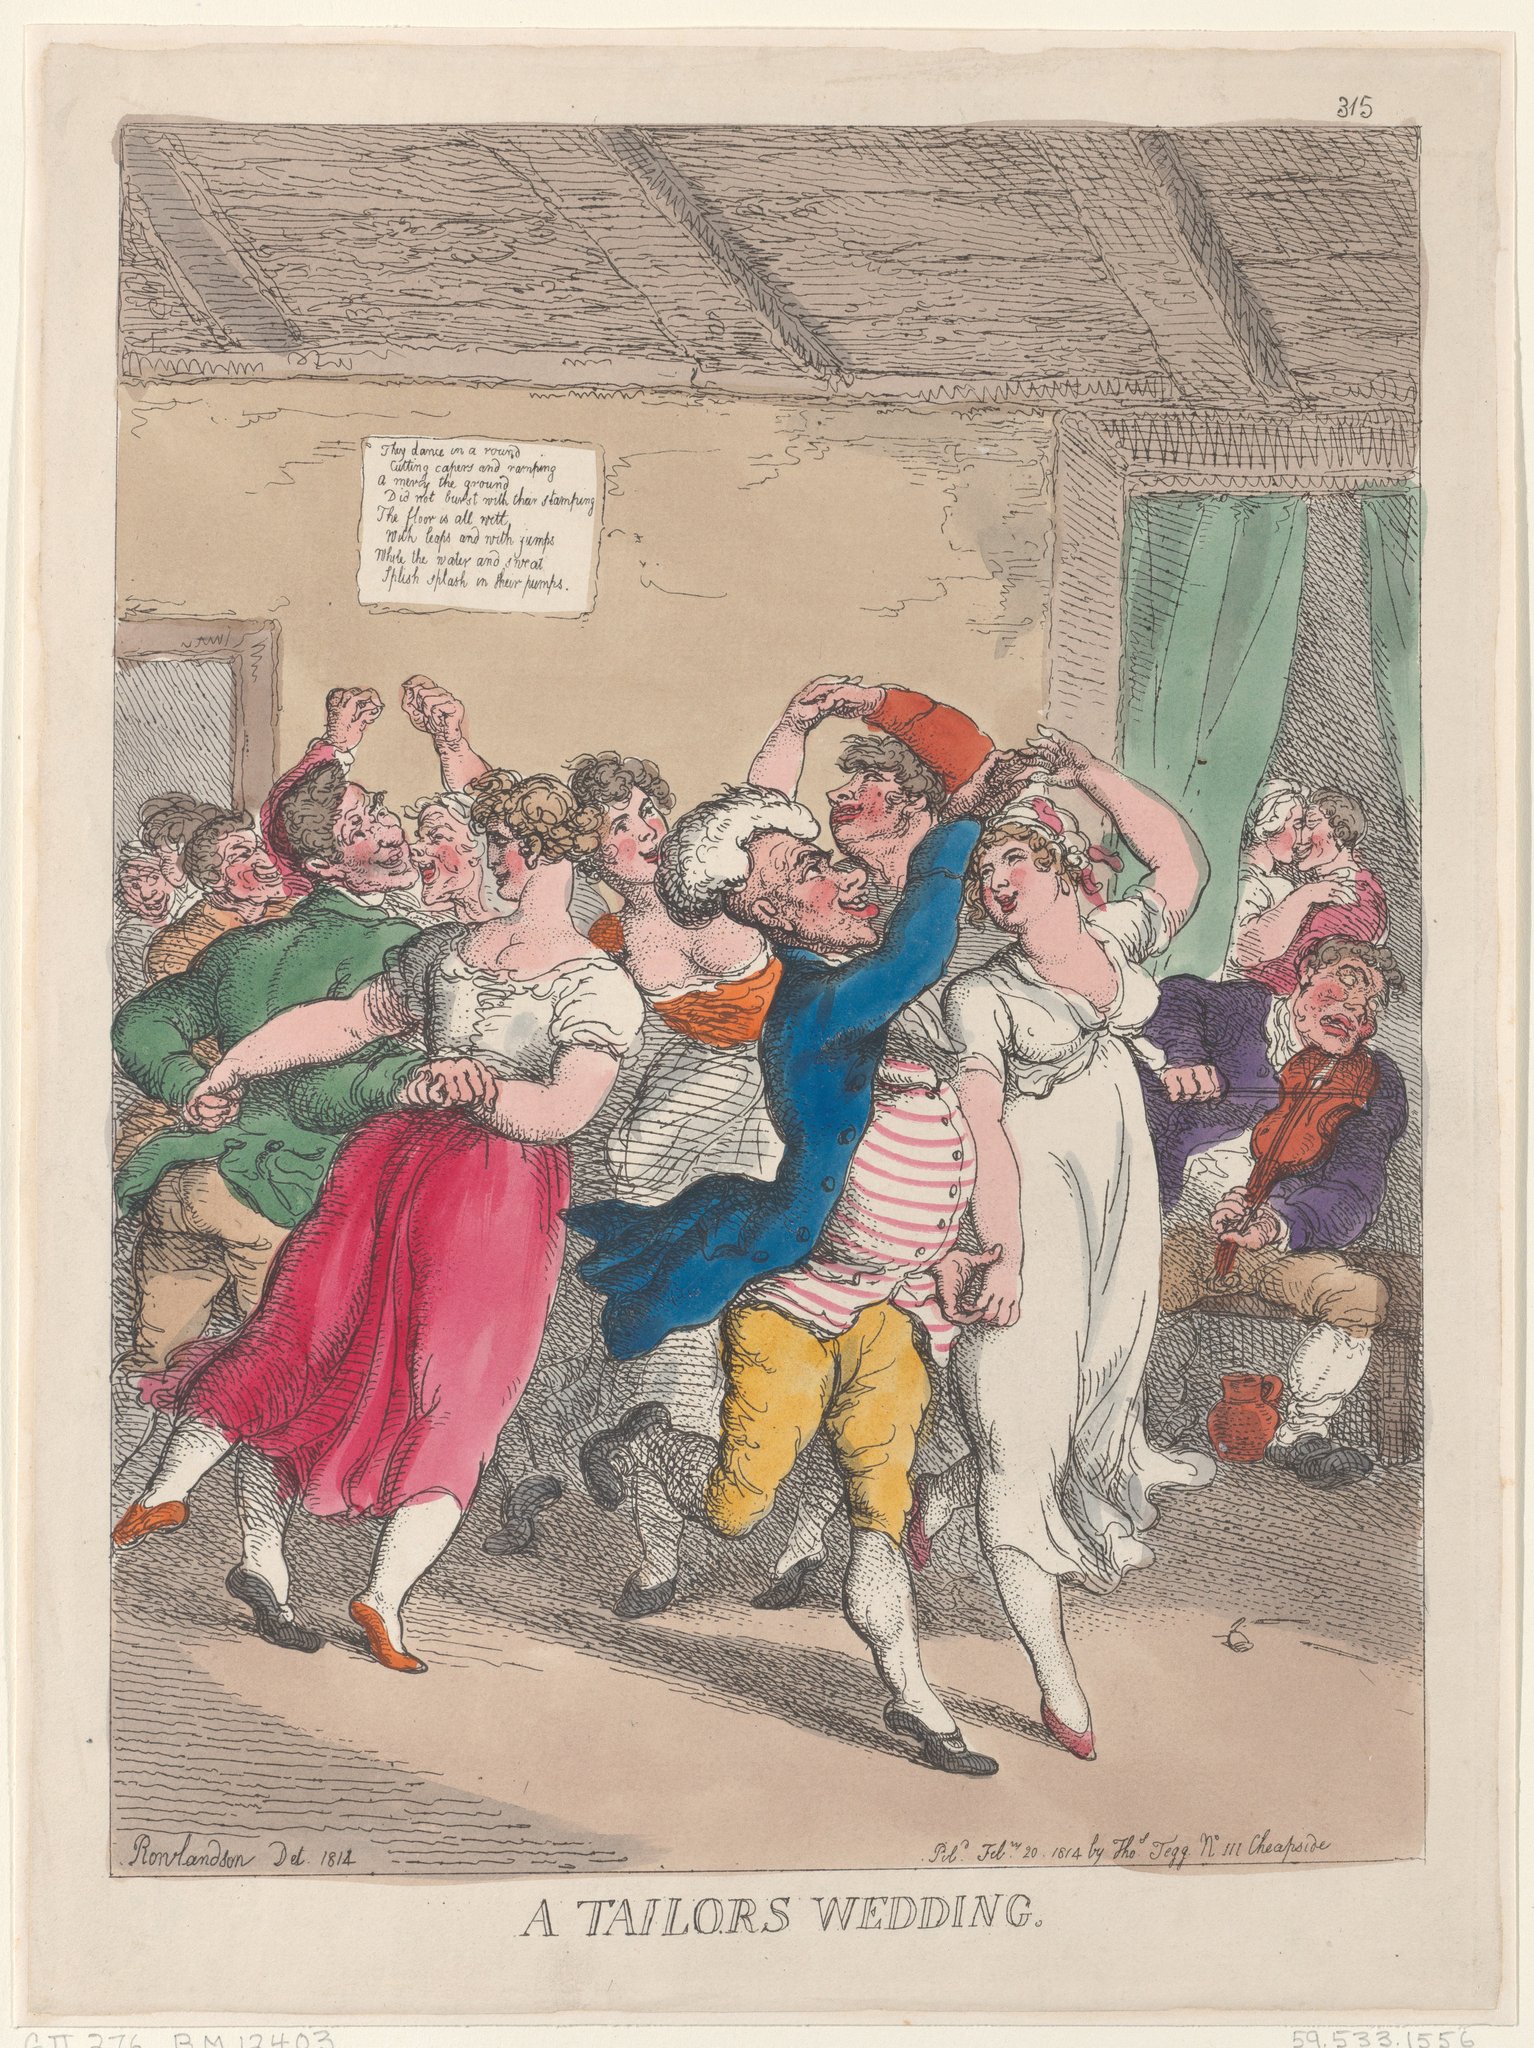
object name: print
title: A Tailors Wedding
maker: thomas rowlandson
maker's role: artist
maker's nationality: british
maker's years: 1757-1827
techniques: etching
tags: men,women,dancing